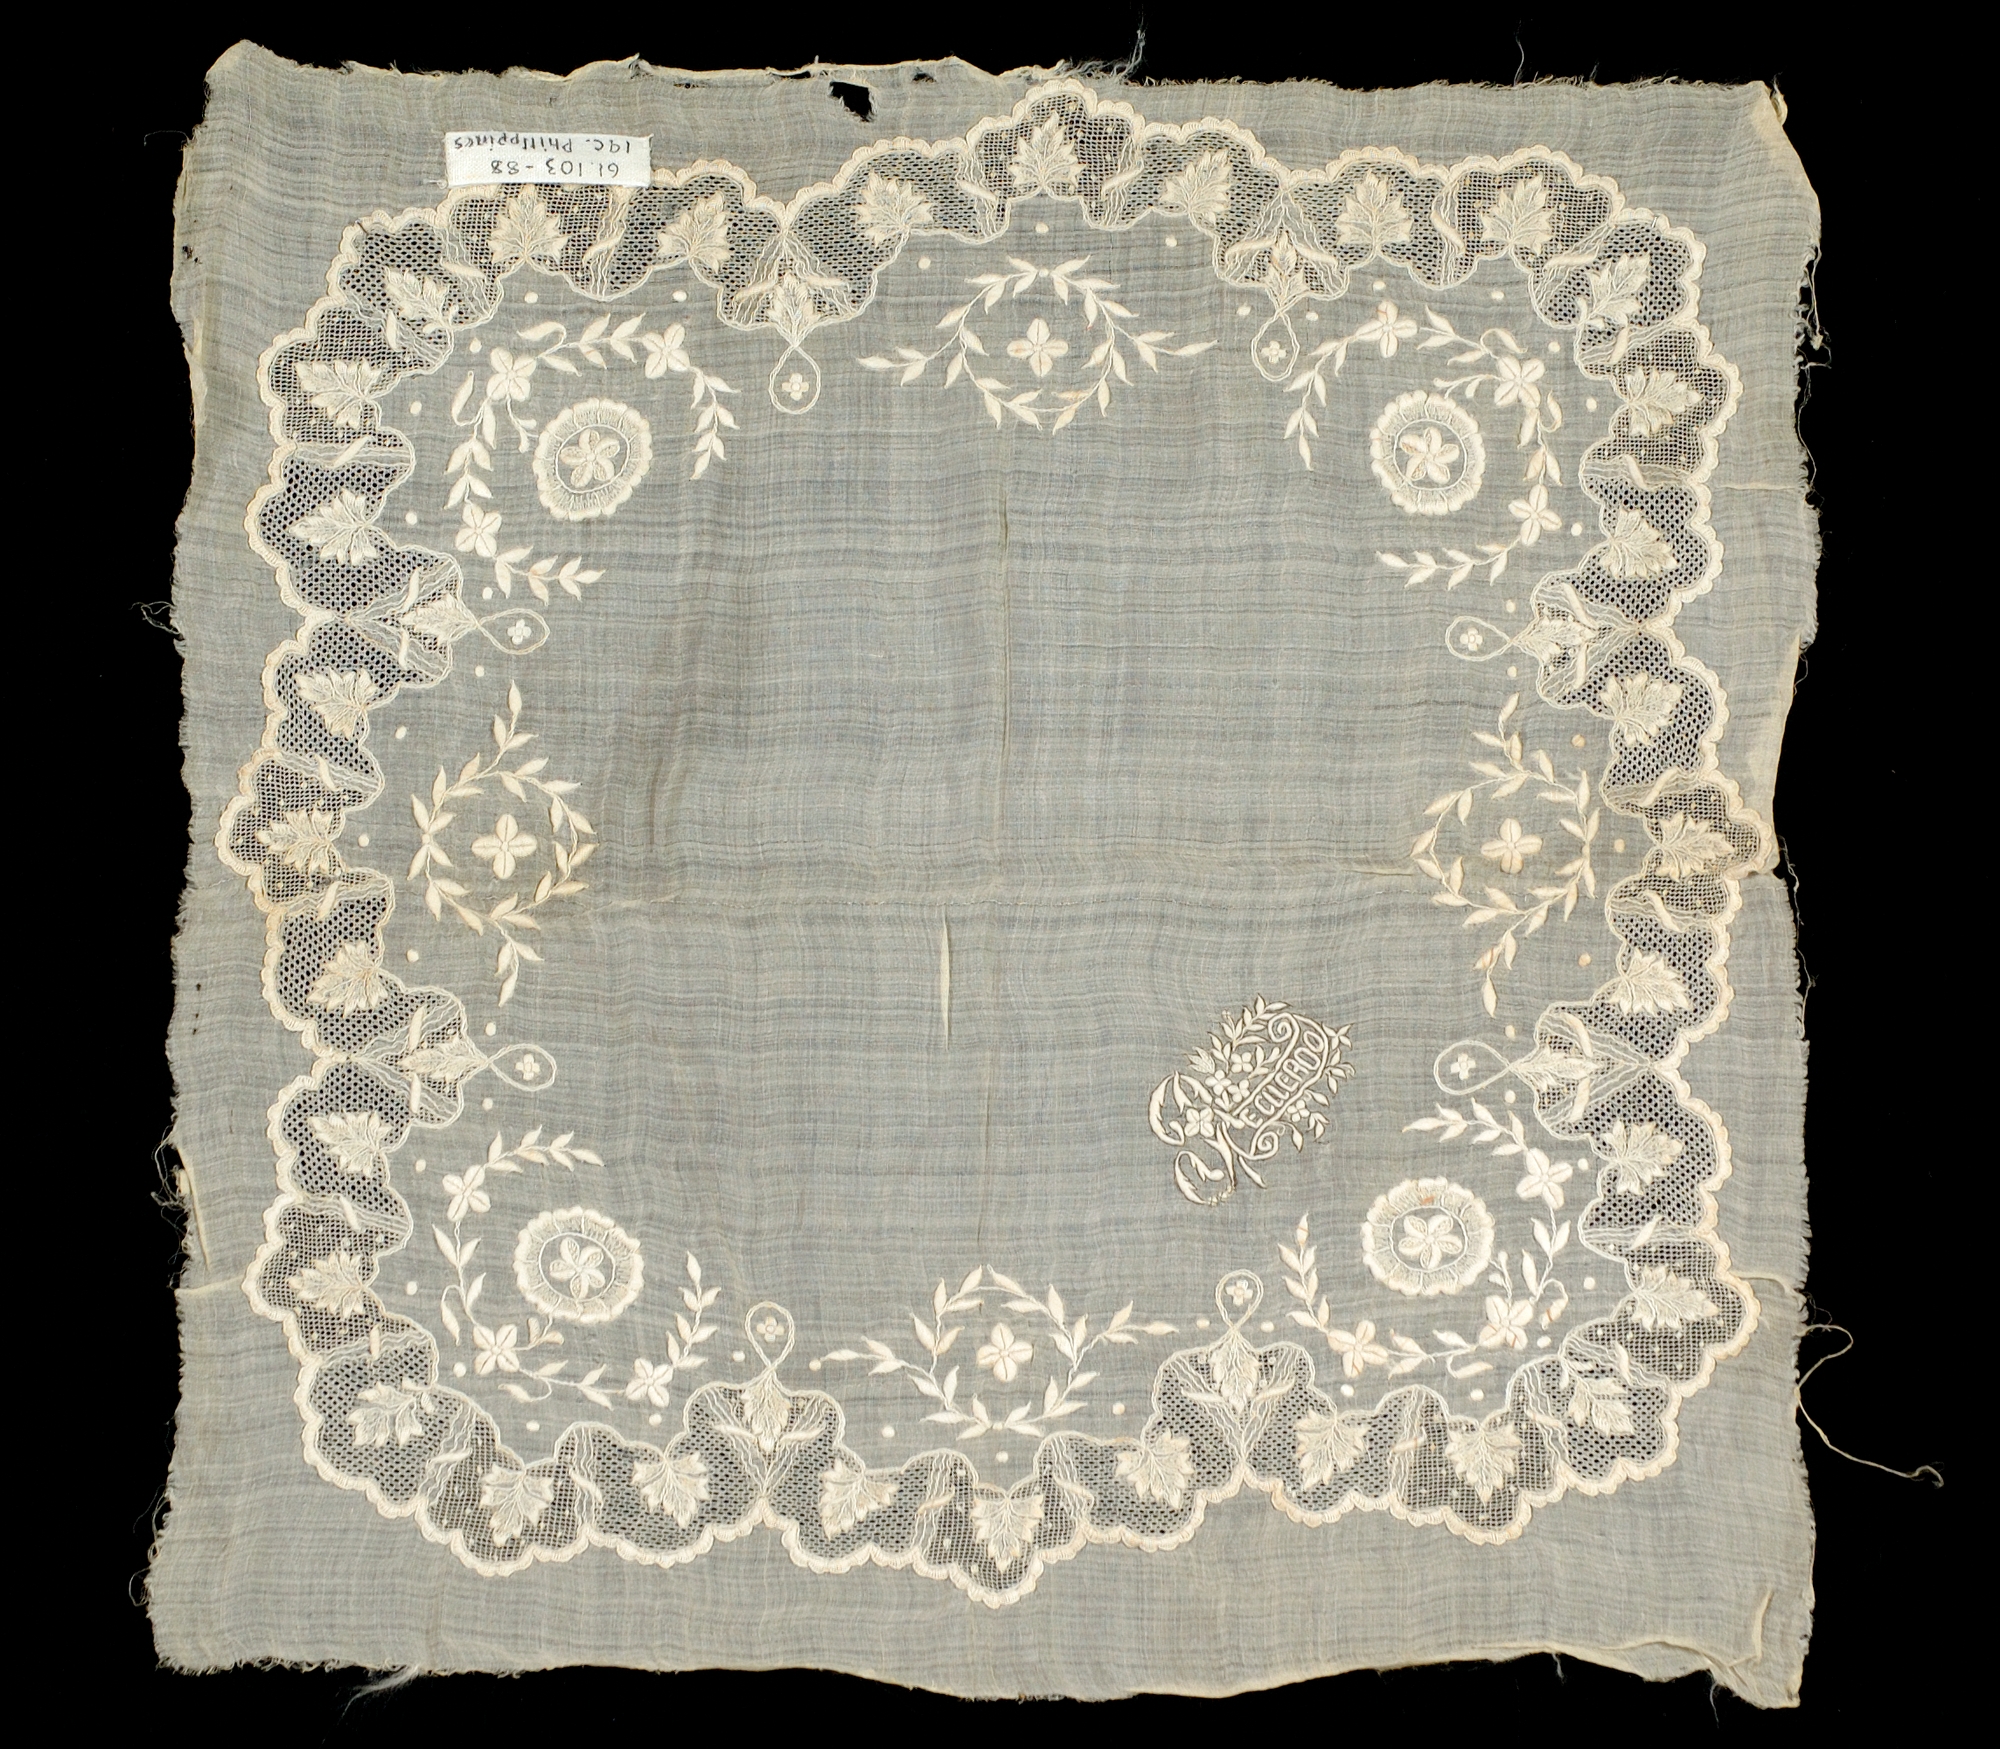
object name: handkerchief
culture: philippine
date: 1876-1900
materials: silk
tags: flowers